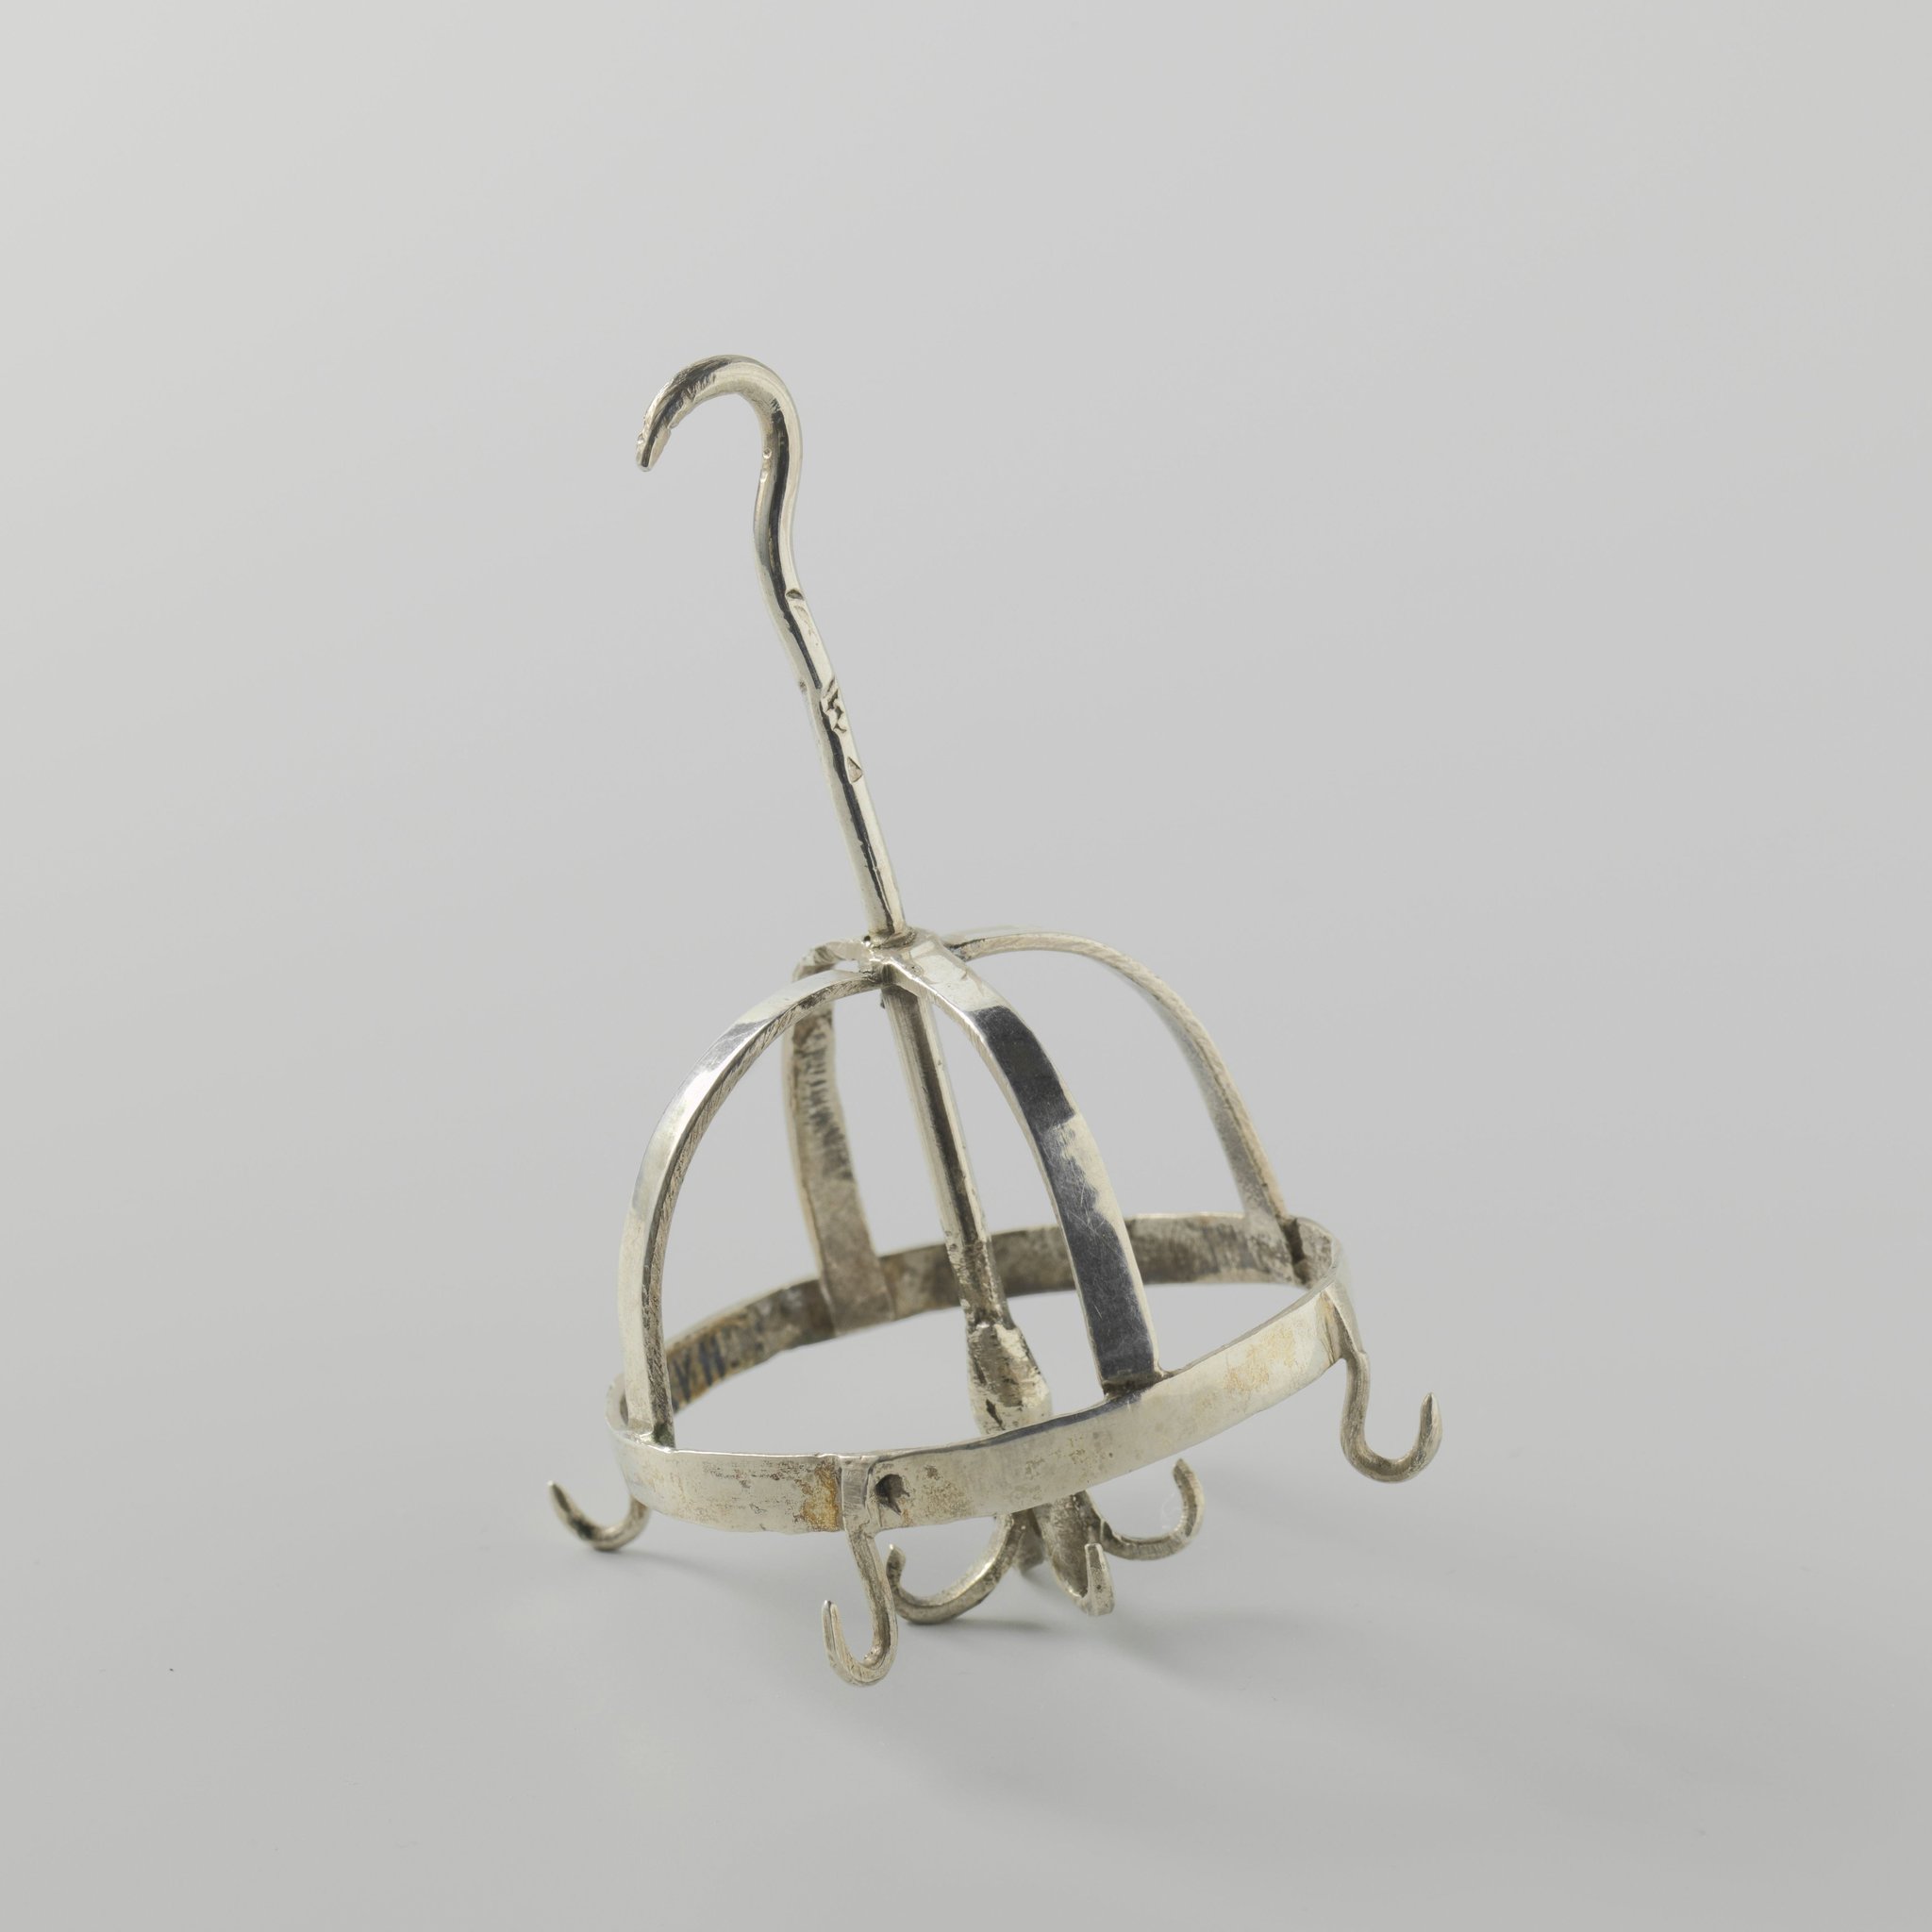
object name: miniature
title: Vleeskroon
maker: wessel jansen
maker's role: silversmith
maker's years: -1696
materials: silver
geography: amsterdam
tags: kitchen-utensils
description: Vleeskroon bestaande uit een ring met vier haken die door middel van vier bogen bevestigd zijn aan een staaf. De bovenkant van de staaf loopt uit in een haak en de onderkant in vier haken. De vleeskroon is gemerkt: mt.= Wessel Jansen en een dolfijn.